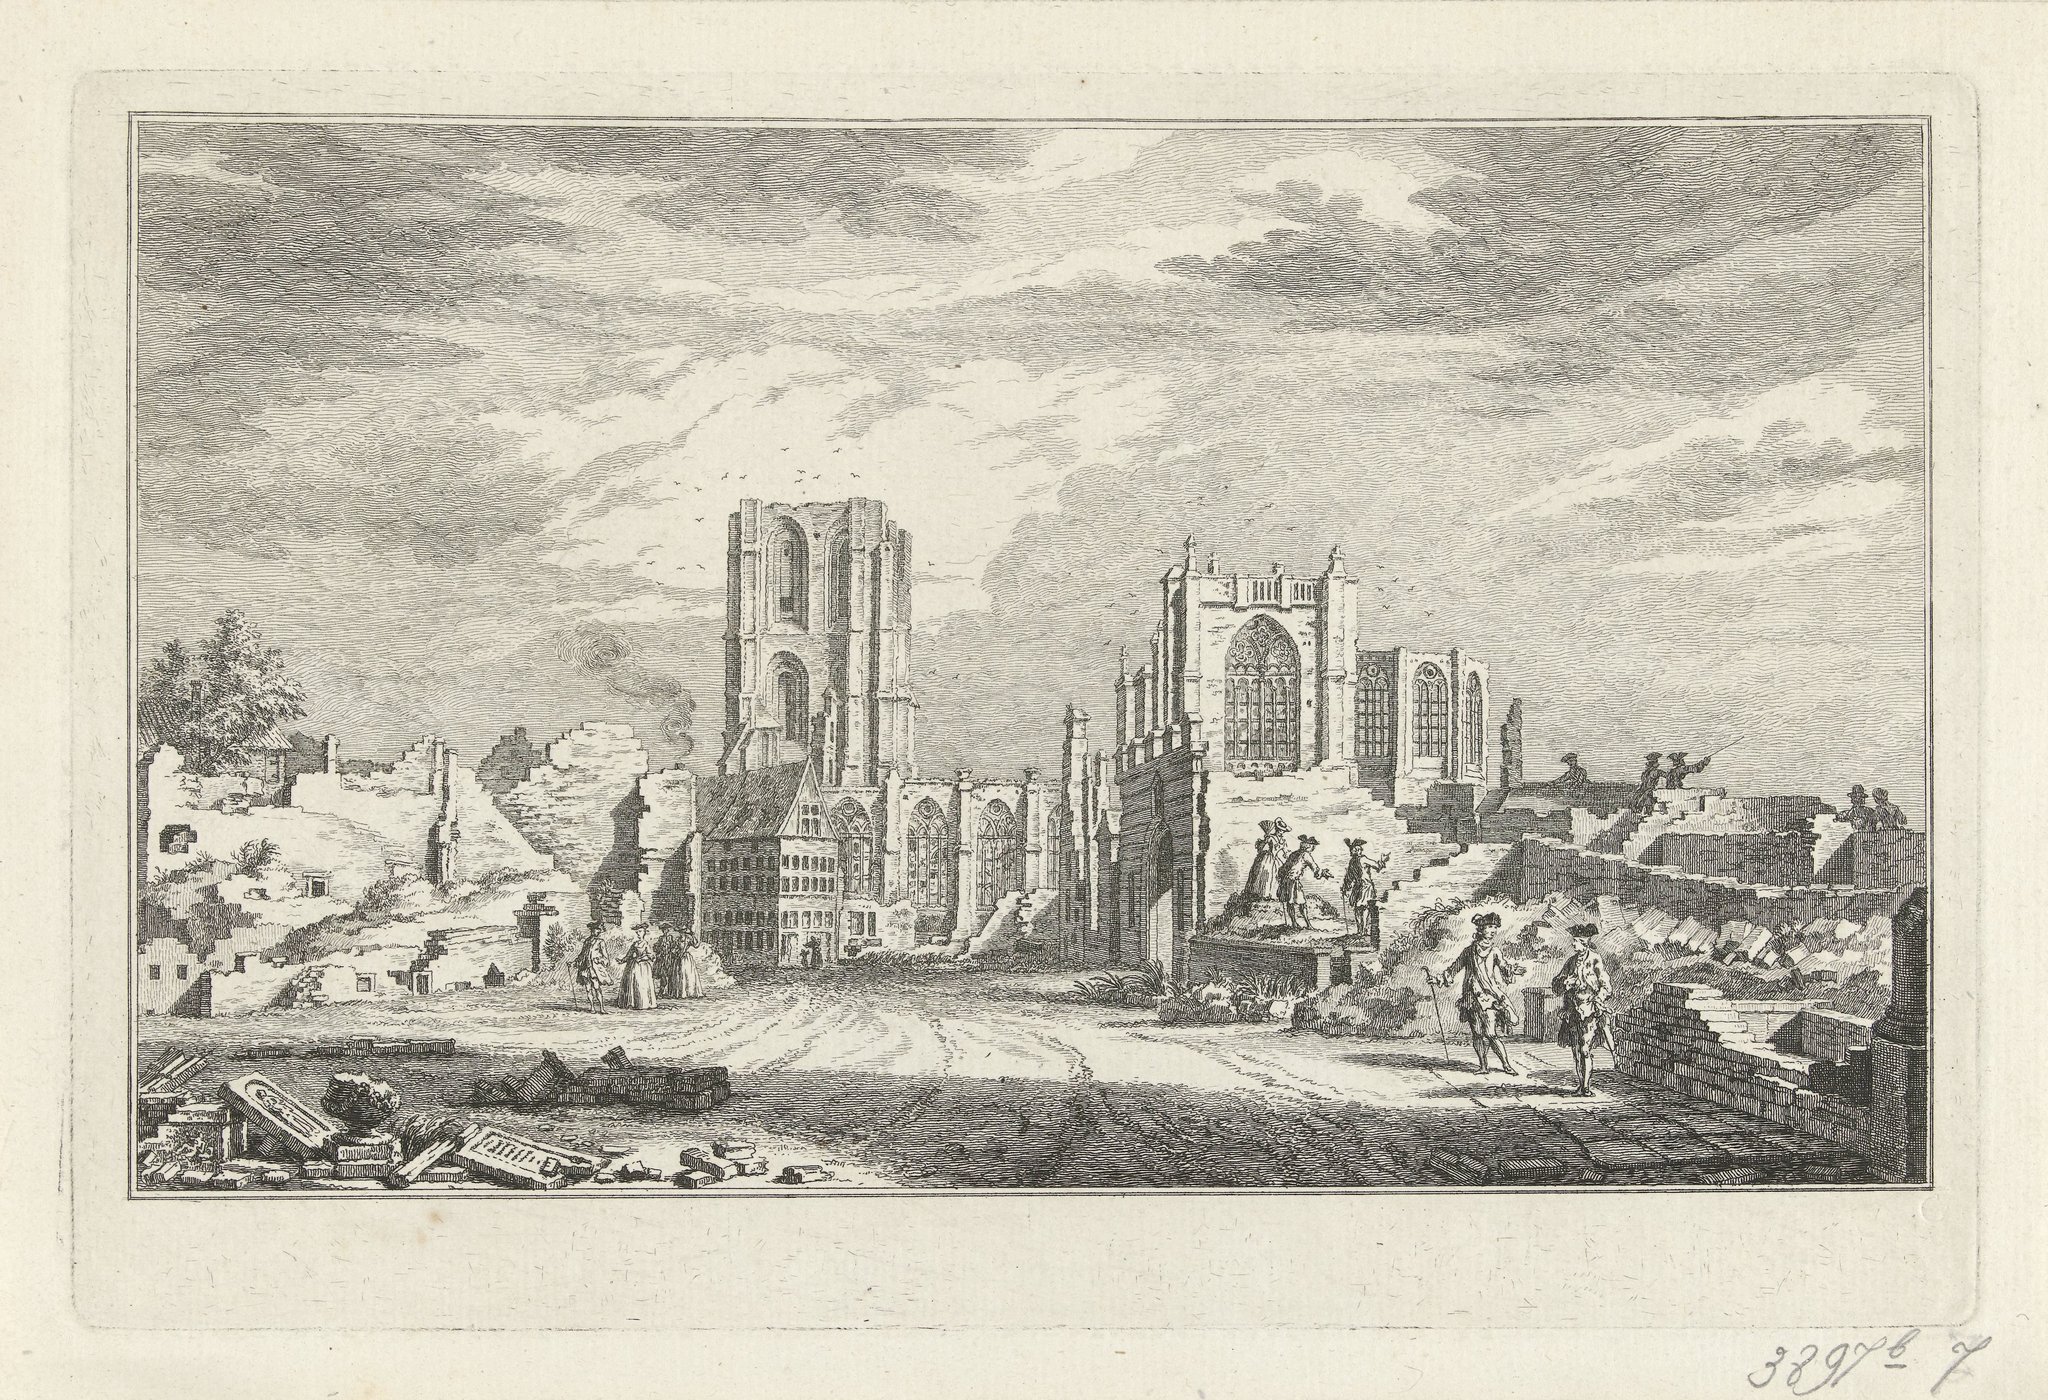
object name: print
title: Ruïne van de Grote Kerk van Bergen op Zoom, 1748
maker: simon fokke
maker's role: draughtsman, print maker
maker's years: 1712-1784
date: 1772-1780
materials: paper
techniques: etching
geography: northern netherlands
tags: ruin of church, monastery, etc., devastated, ruined place or city (~ warfare), bergen op zoom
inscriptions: collector's mark: Lugt 2228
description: Prent ook gebruikt in: Beschryving der stad Bergen op den Zoom (…). 1e druk. Amsterdam: Arend Fokke Simonsz., 1780. Muller geeft aan dat de prenten door Simon Fokke in 1772 naar de tekeningen van Pronk uit 1748 zijn vervaardigd. In de Collecties Thuis in Brabant (collecties in Brabantse musea en archieven) is een ontwerptekening (met inv.nr.: BC-Tha oai:tha.uvt.nl:709121) voor deze prent in de serie bewaard met de annotatie: Hoogstraat. na t Leven geschest (sic) door C.Pronk 1748. opgetekent door S. Fokke 1772.